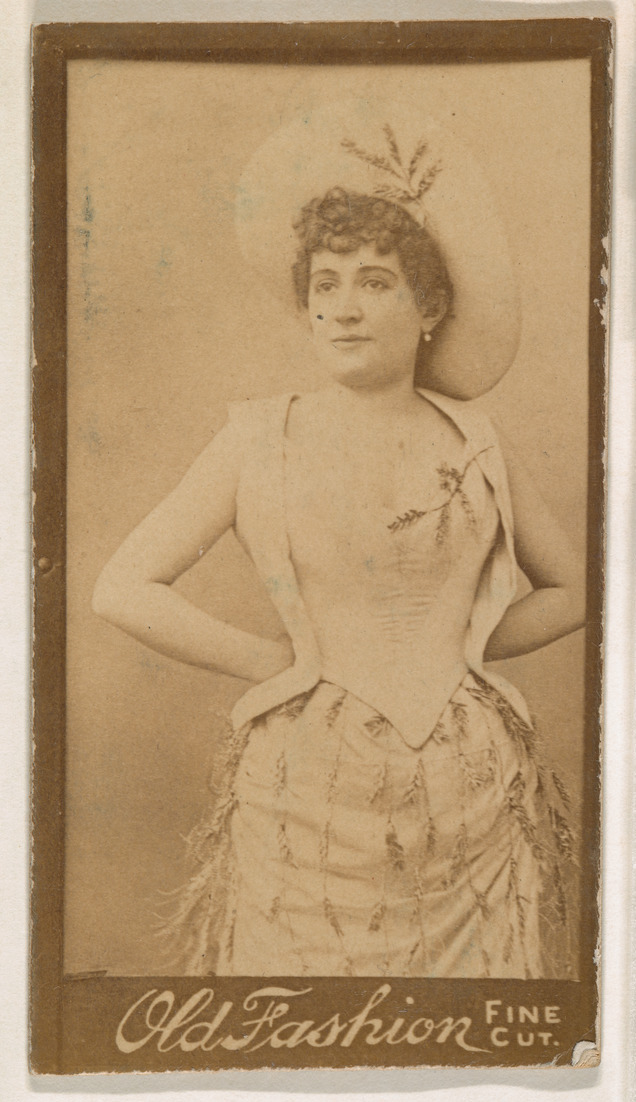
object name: photograph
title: Actress standing with hands on hips, from the Actresses series (N664) promoting Old Fashion Fine Cut Tobacco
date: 1888-1890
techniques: albumen silver print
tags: portraits,women,actresses